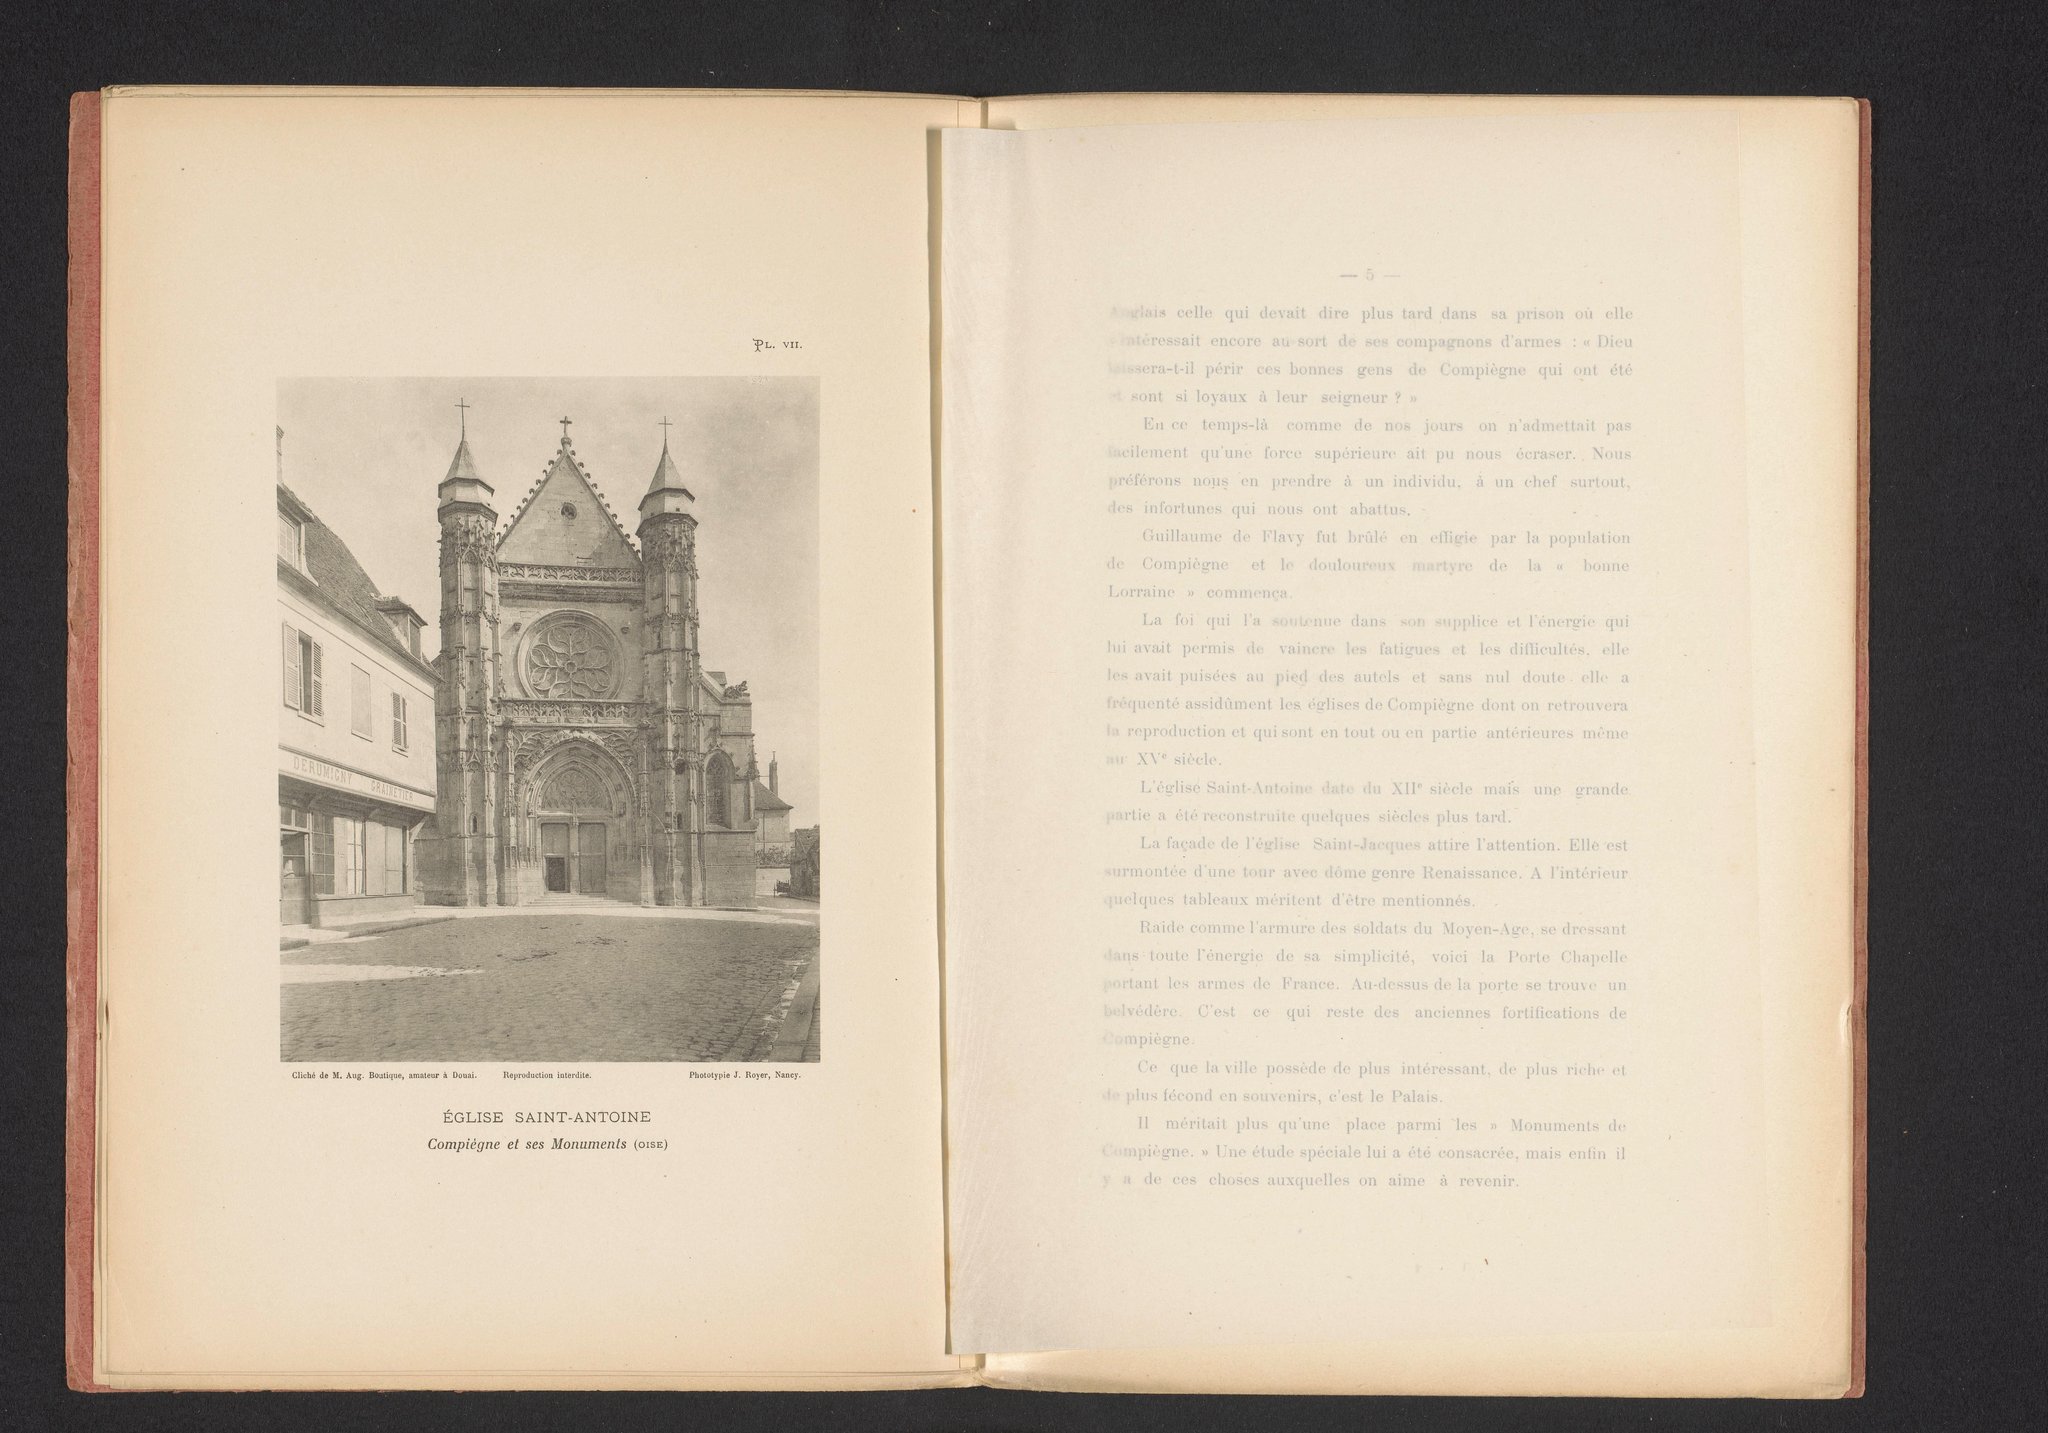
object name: page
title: Église Saint-Antoine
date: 1890-1895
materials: paper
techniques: photograph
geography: compiègne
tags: church (exterior)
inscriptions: inscription: ‘Reproduction interdite.’, number: ‘Pl. VII.’